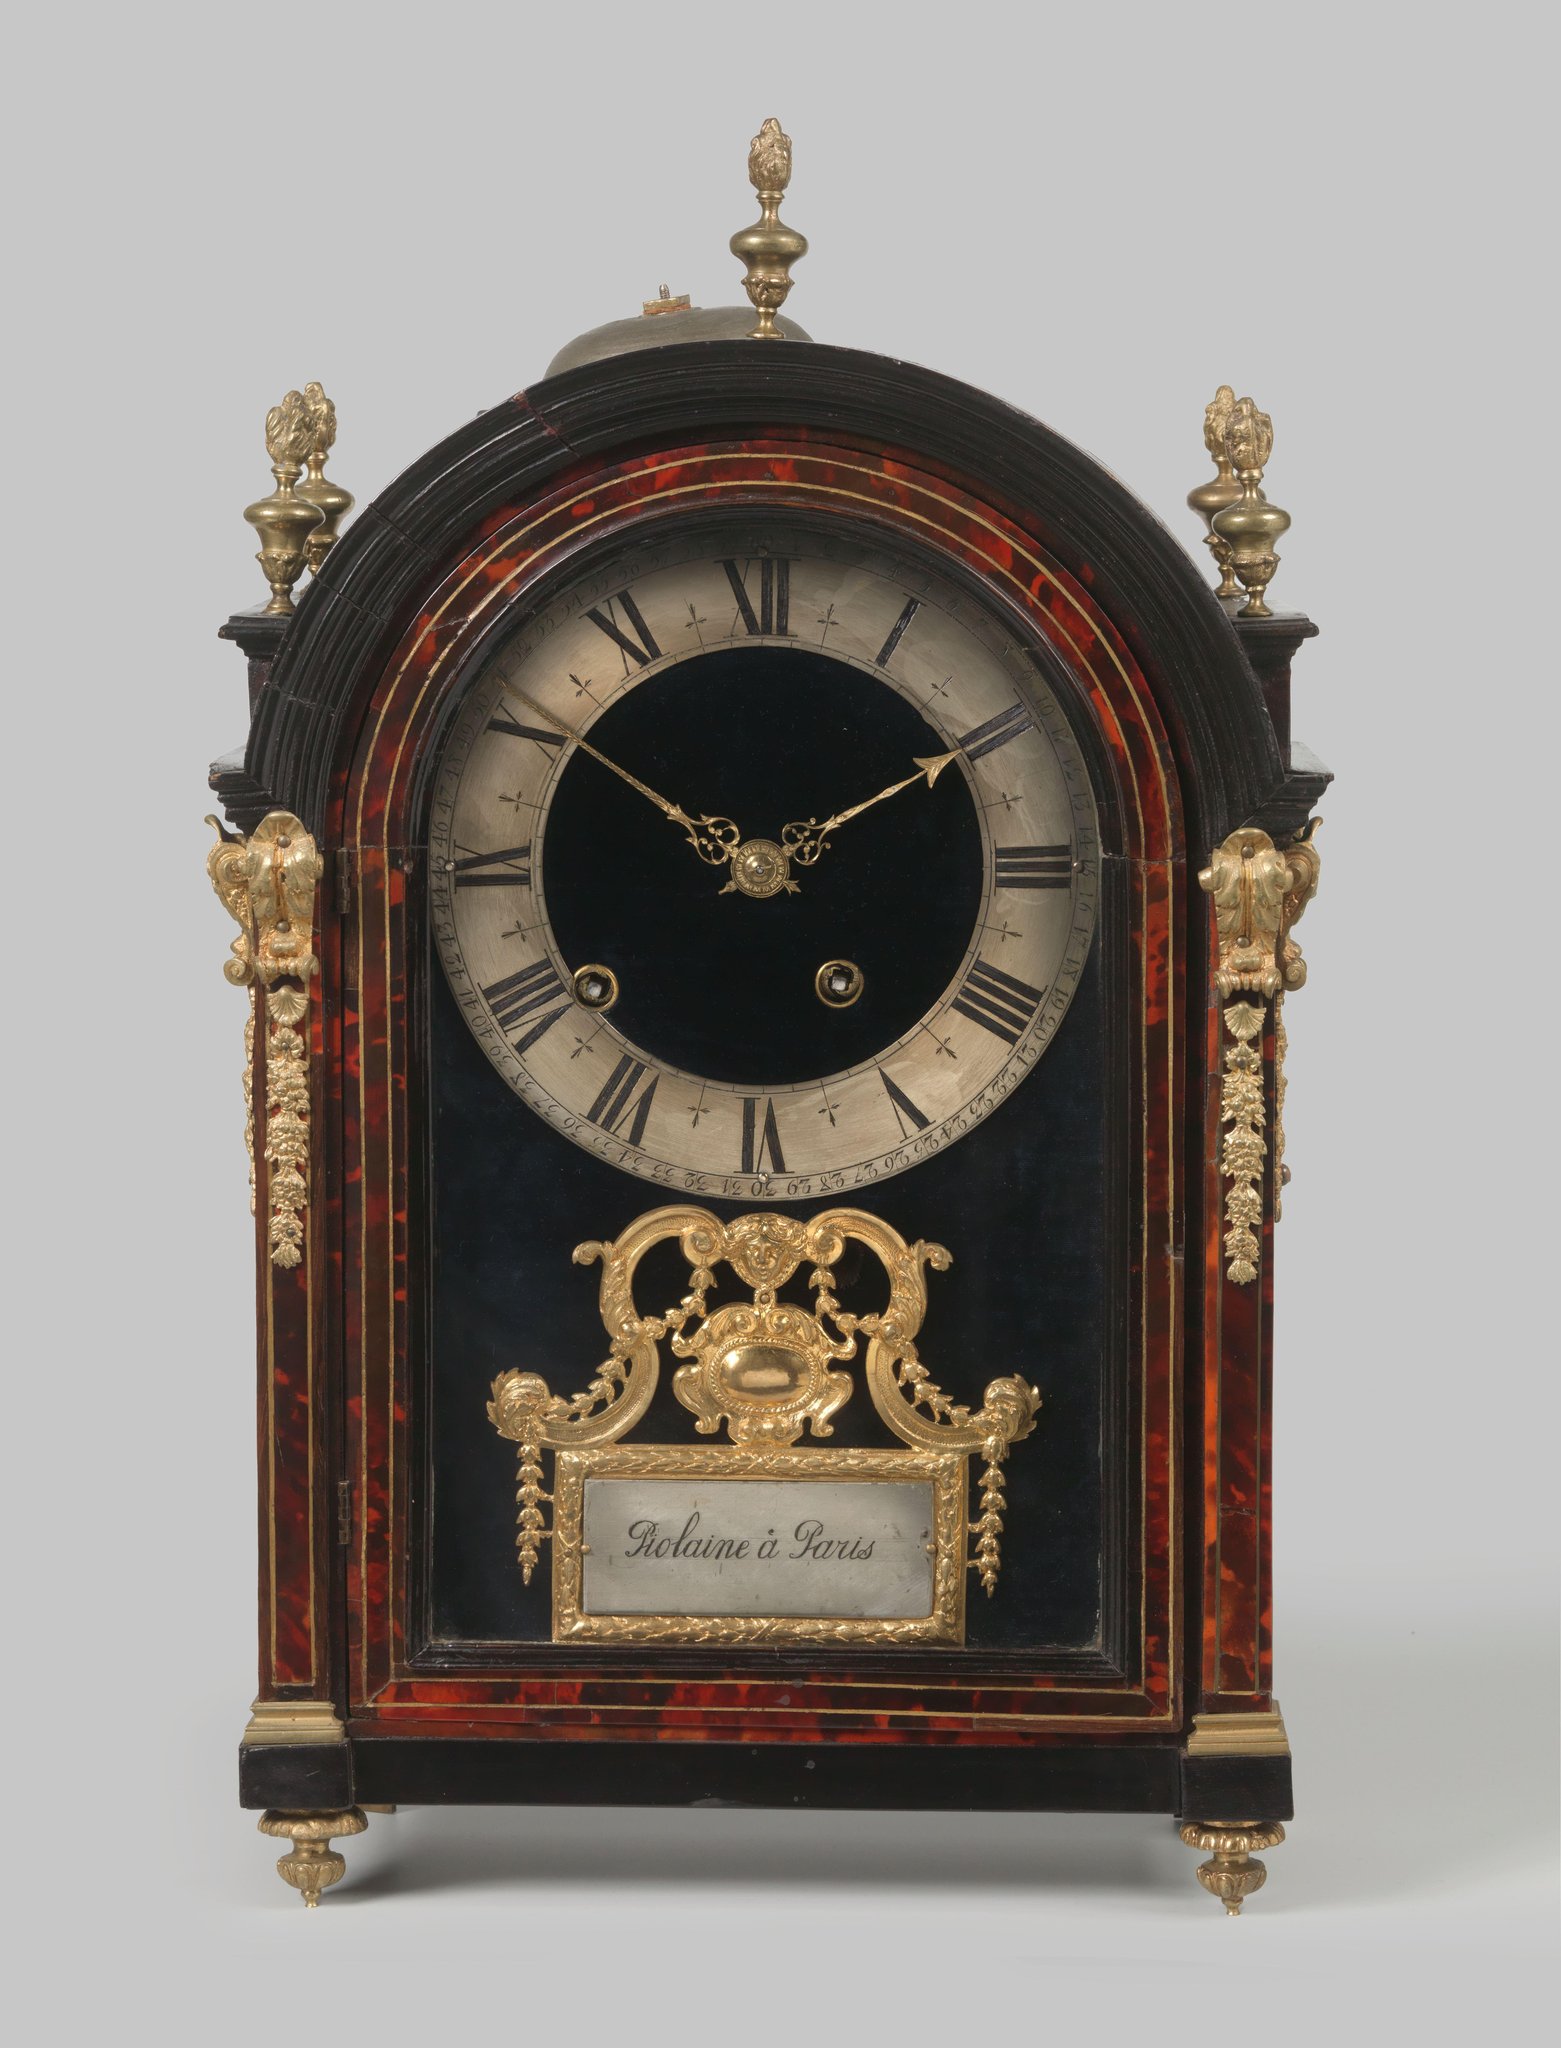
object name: table clock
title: Tafelklok, gefineerd met schildpad en zwart perenhout, en met verguld bronzen lijsten. Bekroond met vijf vazen met vlammen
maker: michel-françois piolaine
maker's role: clockmaker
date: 1700-1725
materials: brass, bronze, wood, silk, tin, shell, velvet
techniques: gilding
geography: paris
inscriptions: : ‘R. May’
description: Bracket clock. Veneered with tortoiseshell. Paris, c. 1675 - 1680. The movement renewed, probably c. 1770 - 1790 by Piolaine.